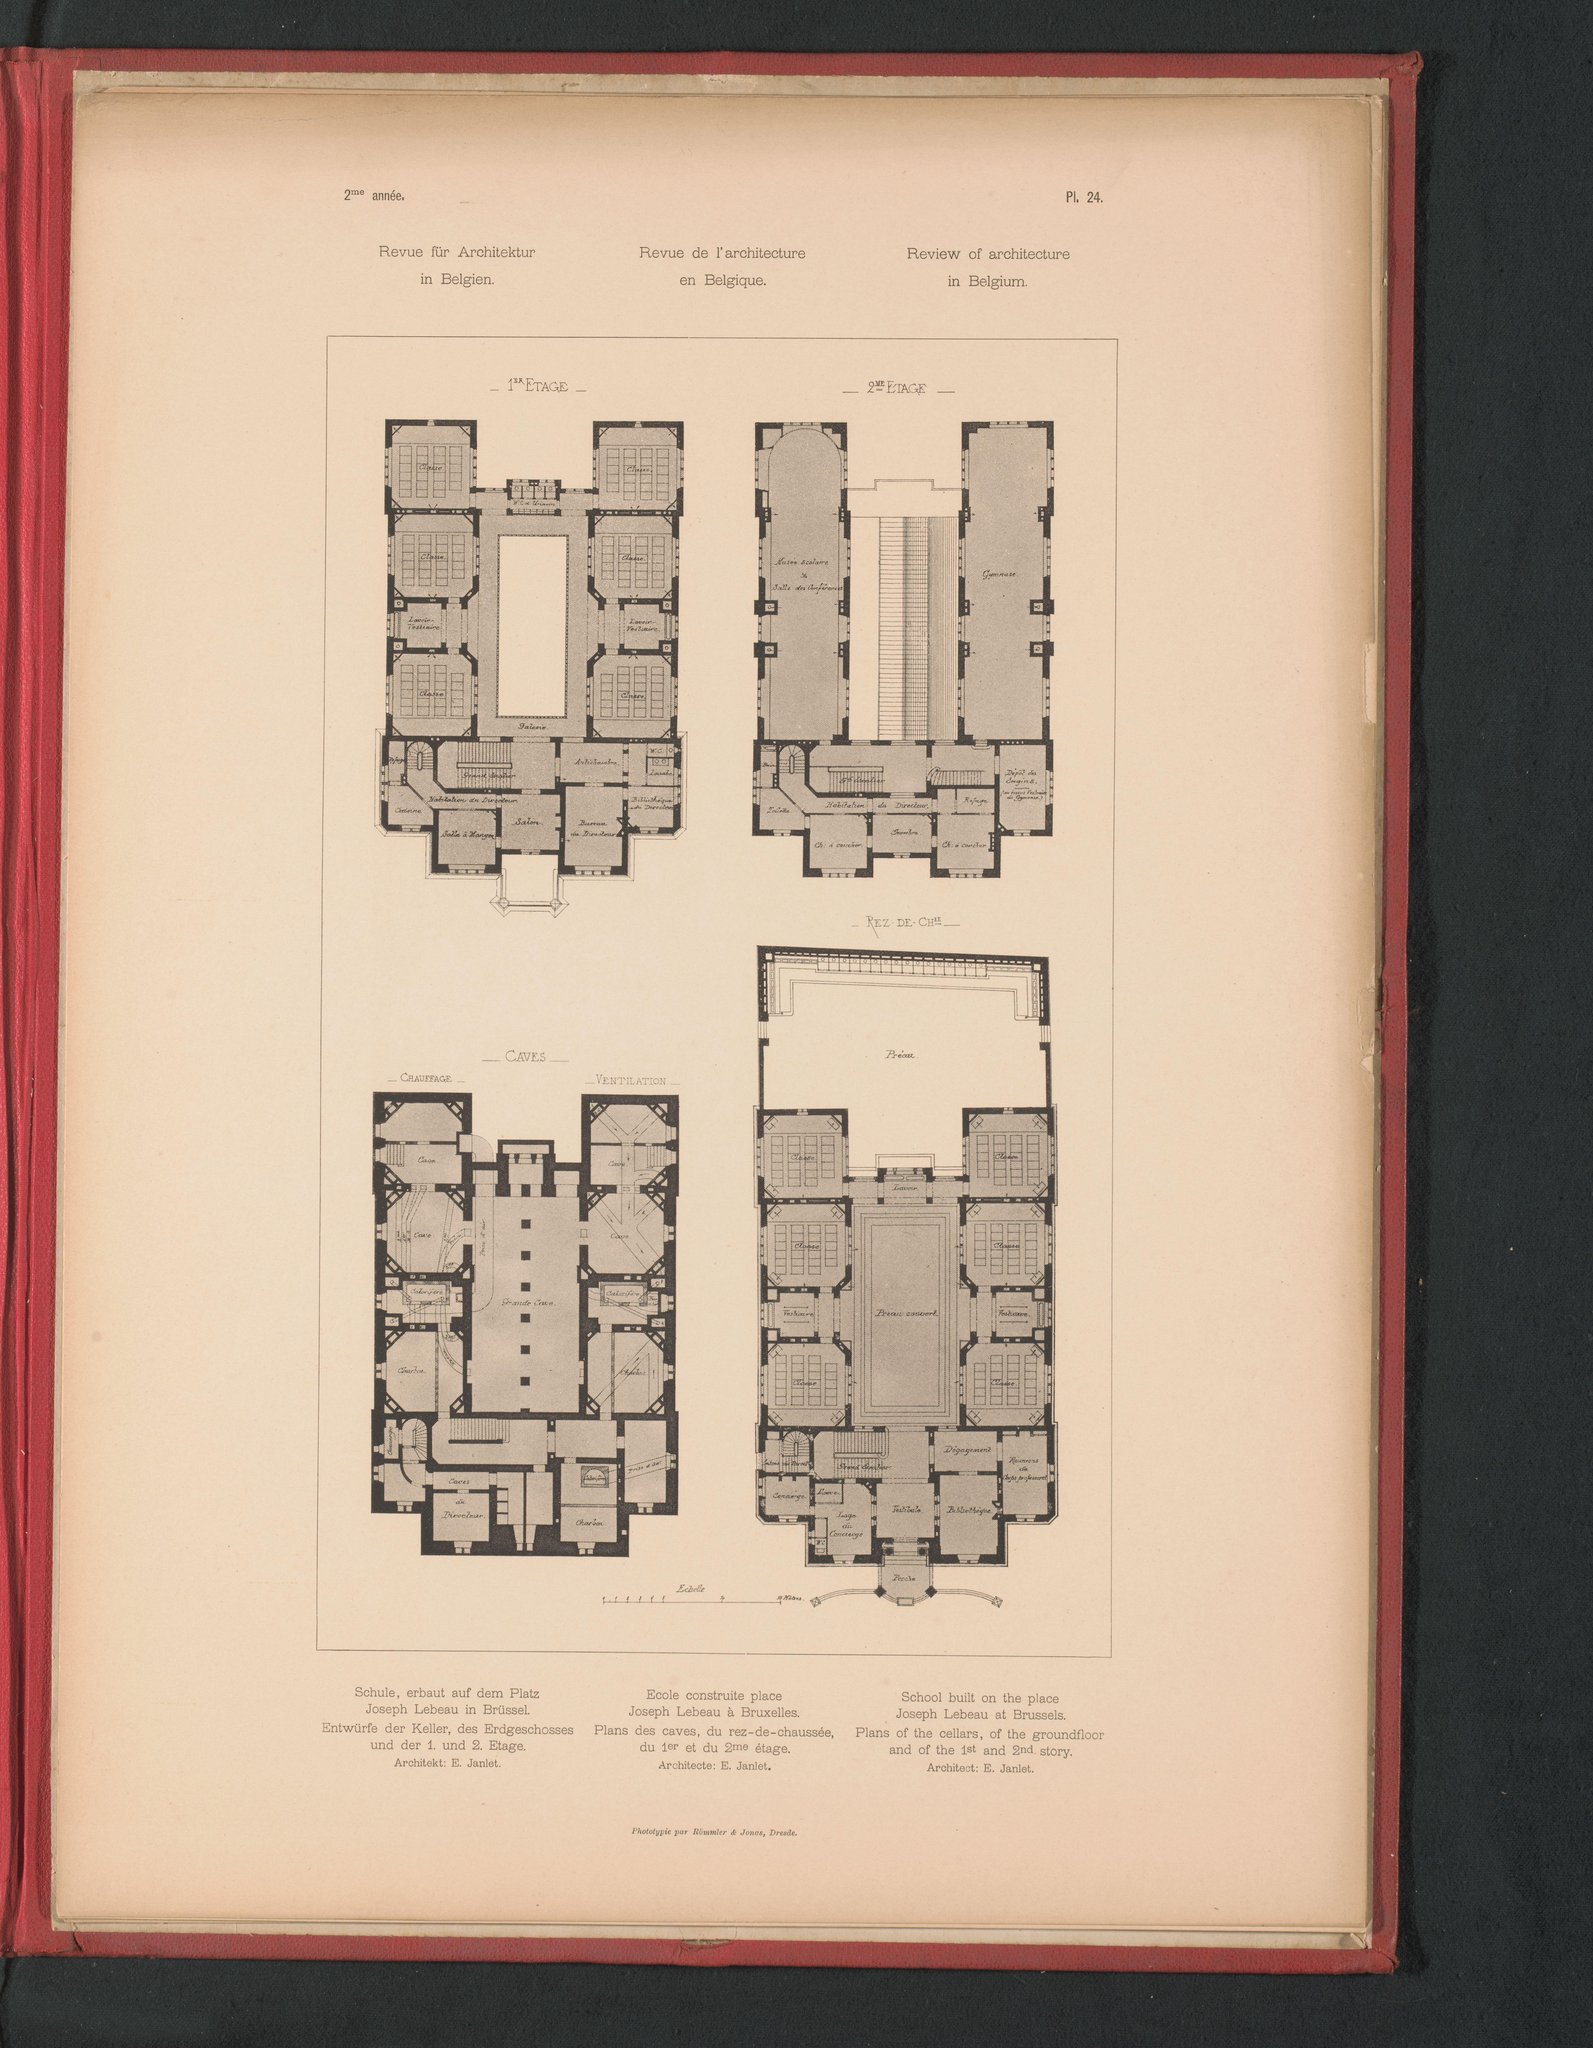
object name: reproduction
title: Revue für Architektur in Belgien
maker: émile janlet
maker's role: architect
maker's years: 1839-1919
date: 1888-1893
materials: paper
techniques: photograph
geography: dresden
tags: housing, plan ~ architecture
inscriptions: number: ‘Pl. 24.’, inscription: ‘2me. année.’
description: Deze prent maakt deel uit van een omslag met 110 prenten op 90 bladen en 18 tekstbladen.